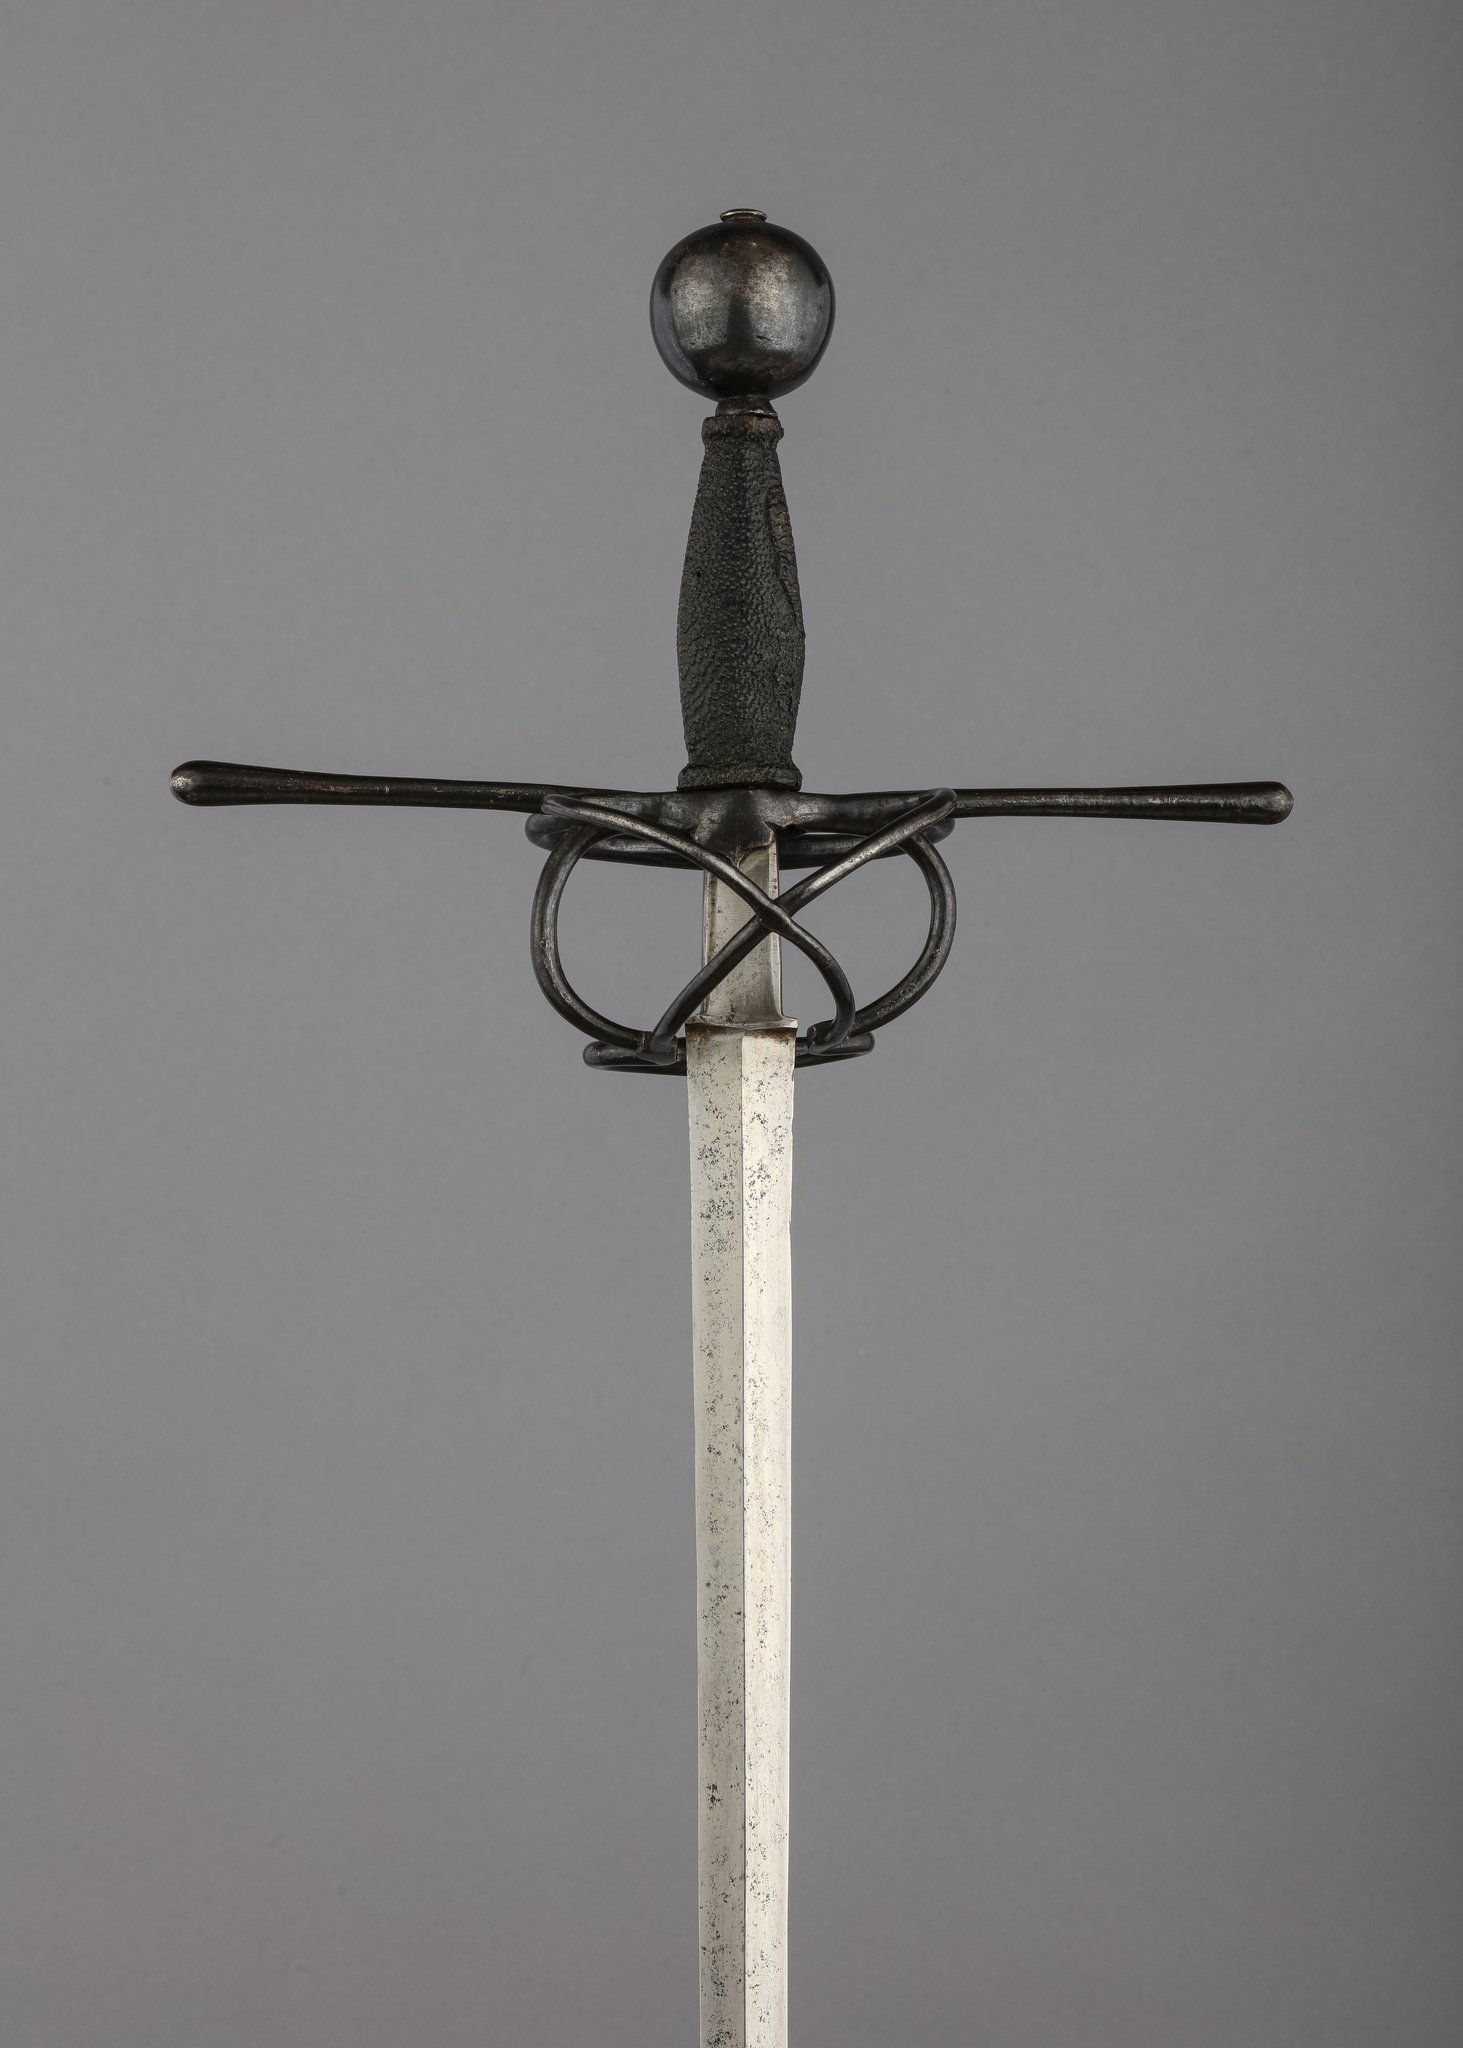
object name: rapier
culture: german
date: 1575-1600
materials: steel, wood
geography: germany